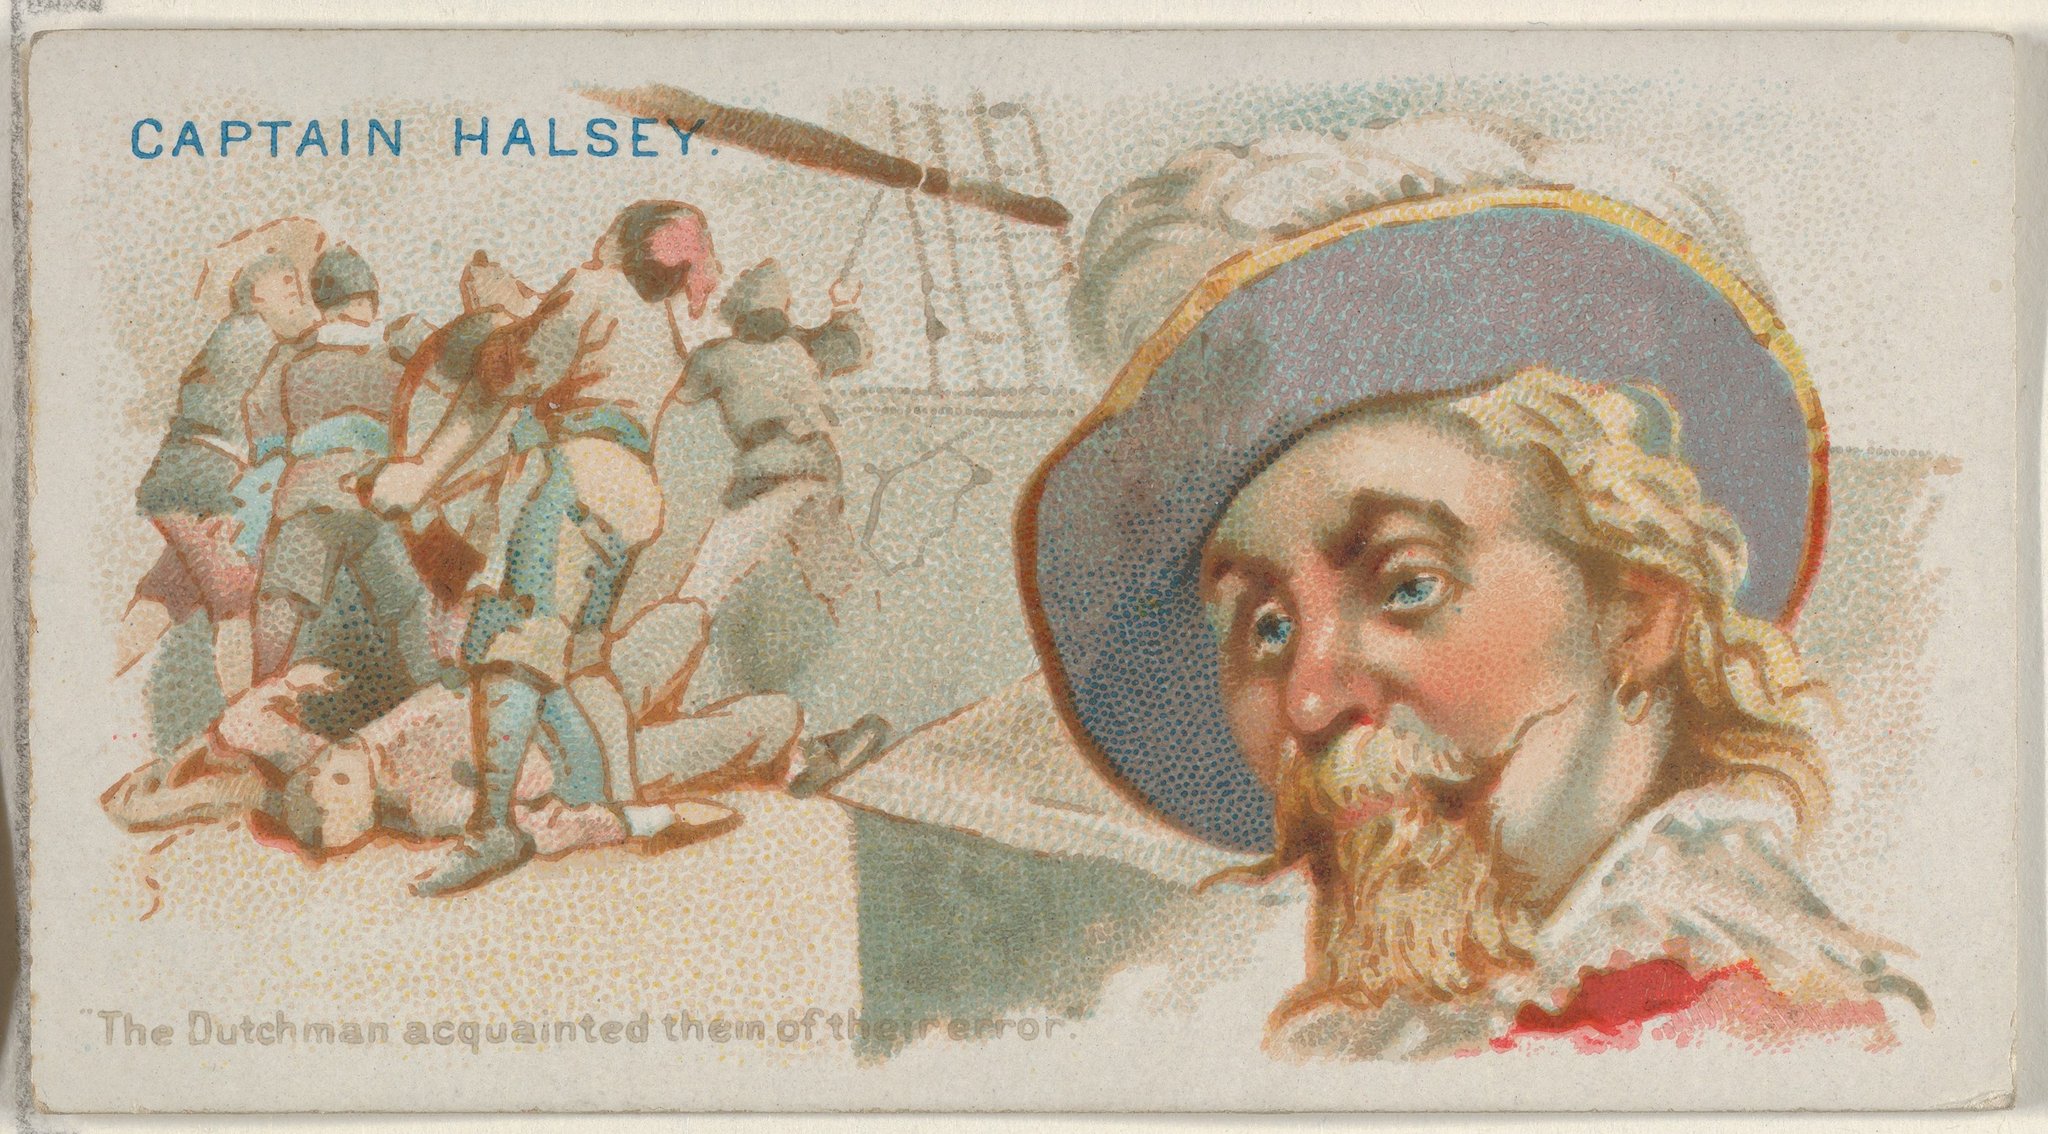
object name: print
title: Captain Halsey, The Dutchman Acquainted them of this Error, from the Pirates of the Spanish Main series (N19) for Allen & Ginter Cigarettes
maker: allen & ginter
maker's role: publisher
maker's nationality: american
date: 1888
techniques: color lithograph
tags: men